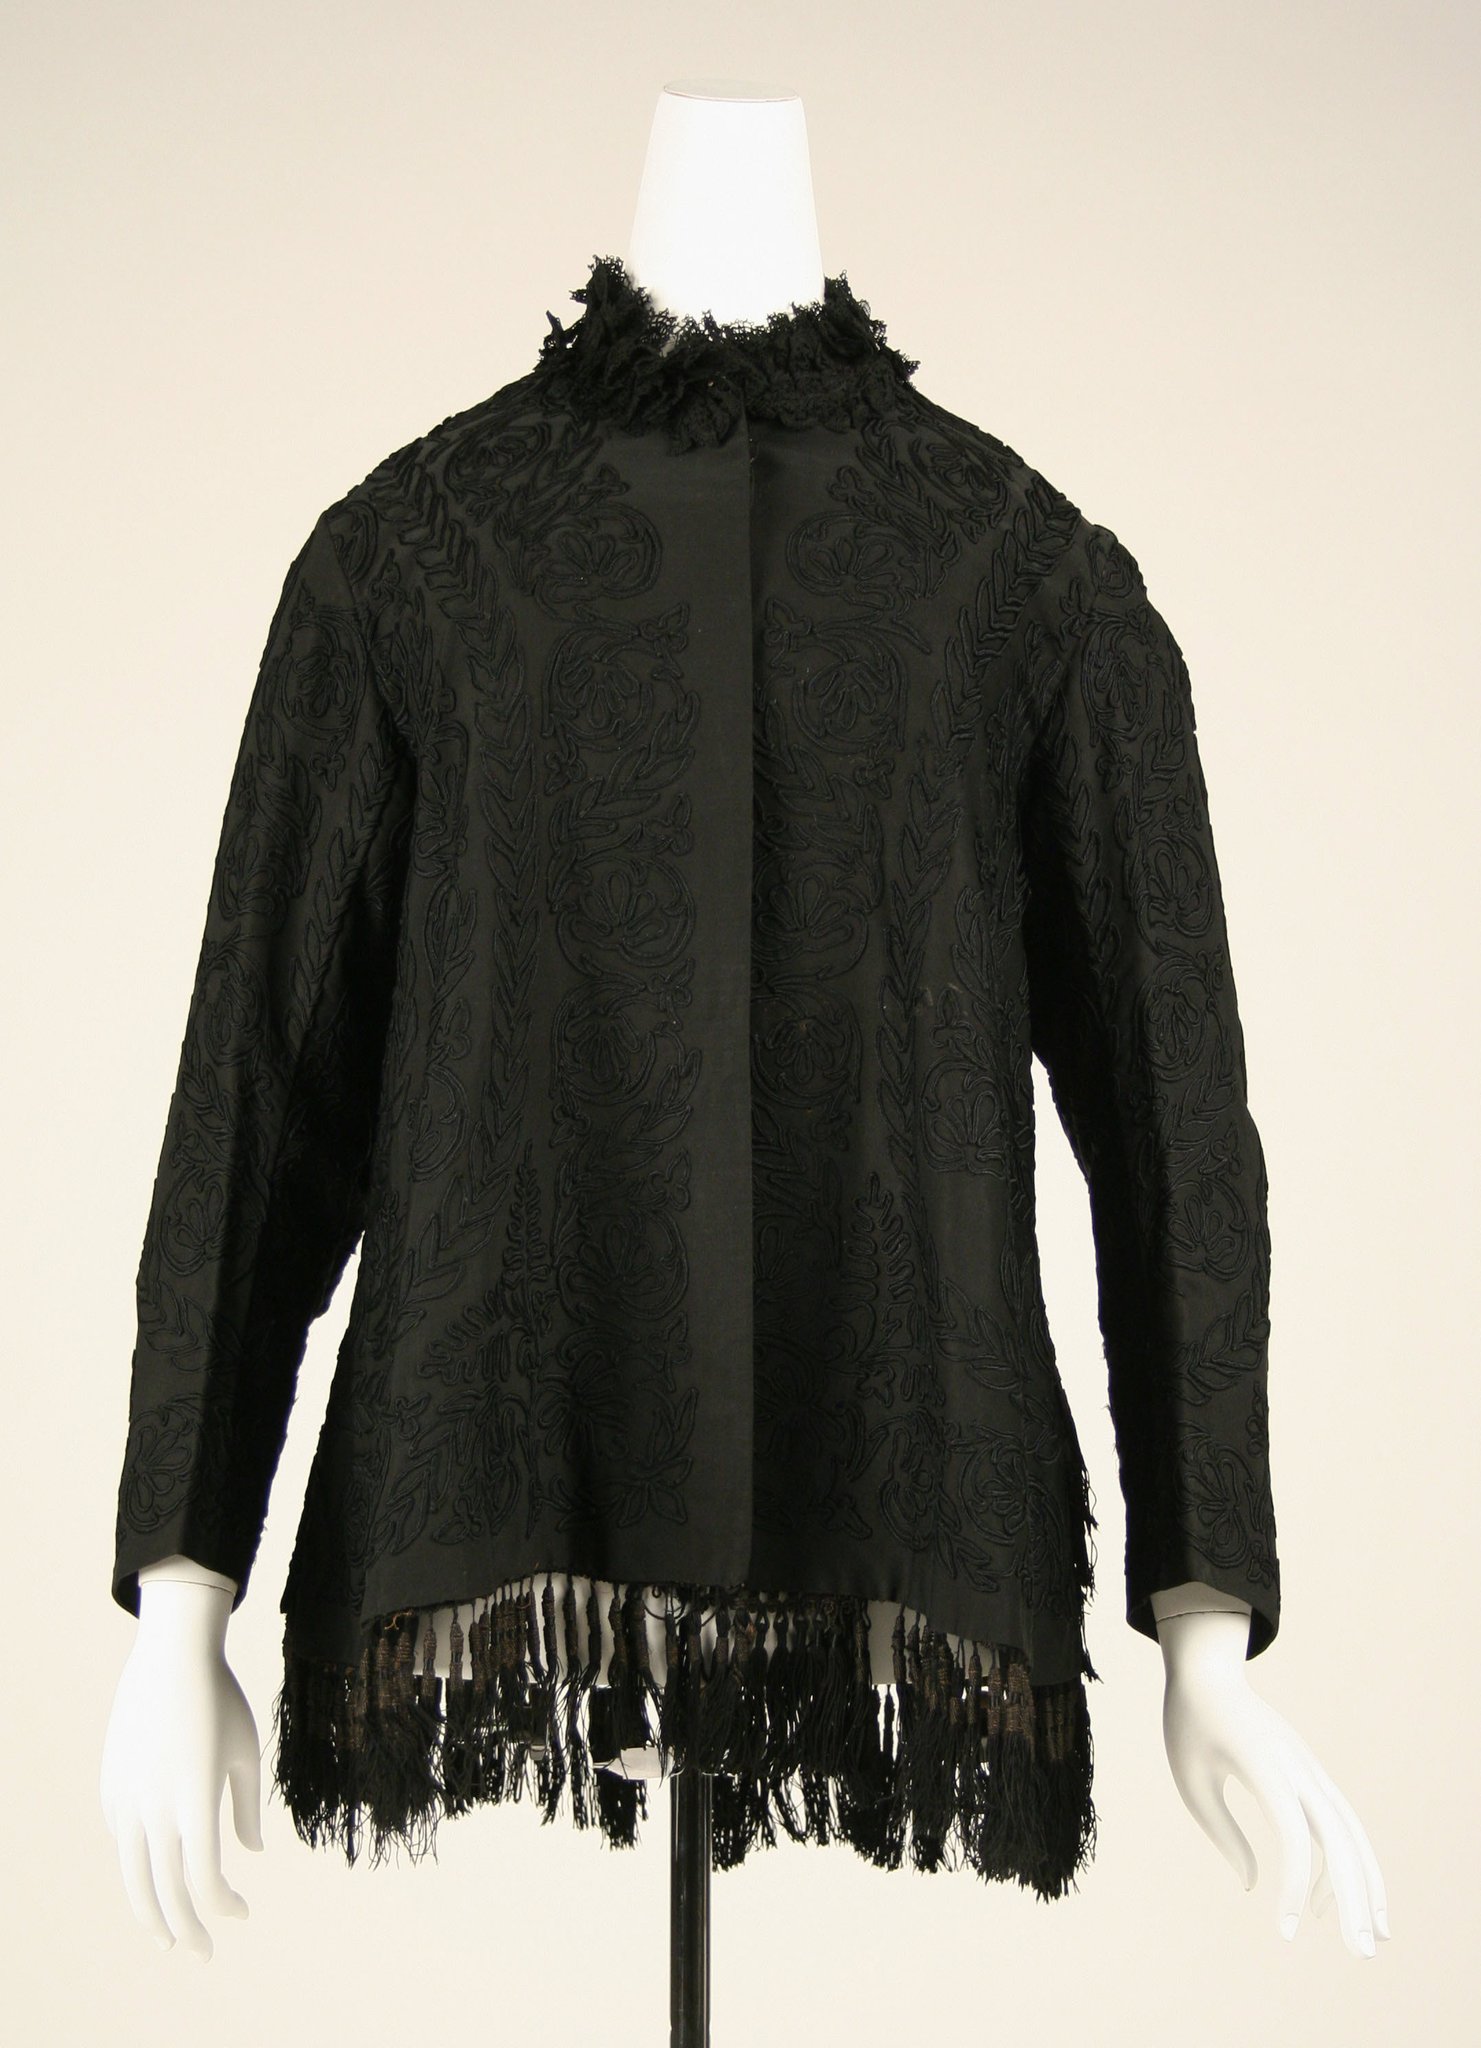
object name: dolman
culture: american or european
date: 1865-1875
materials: wool